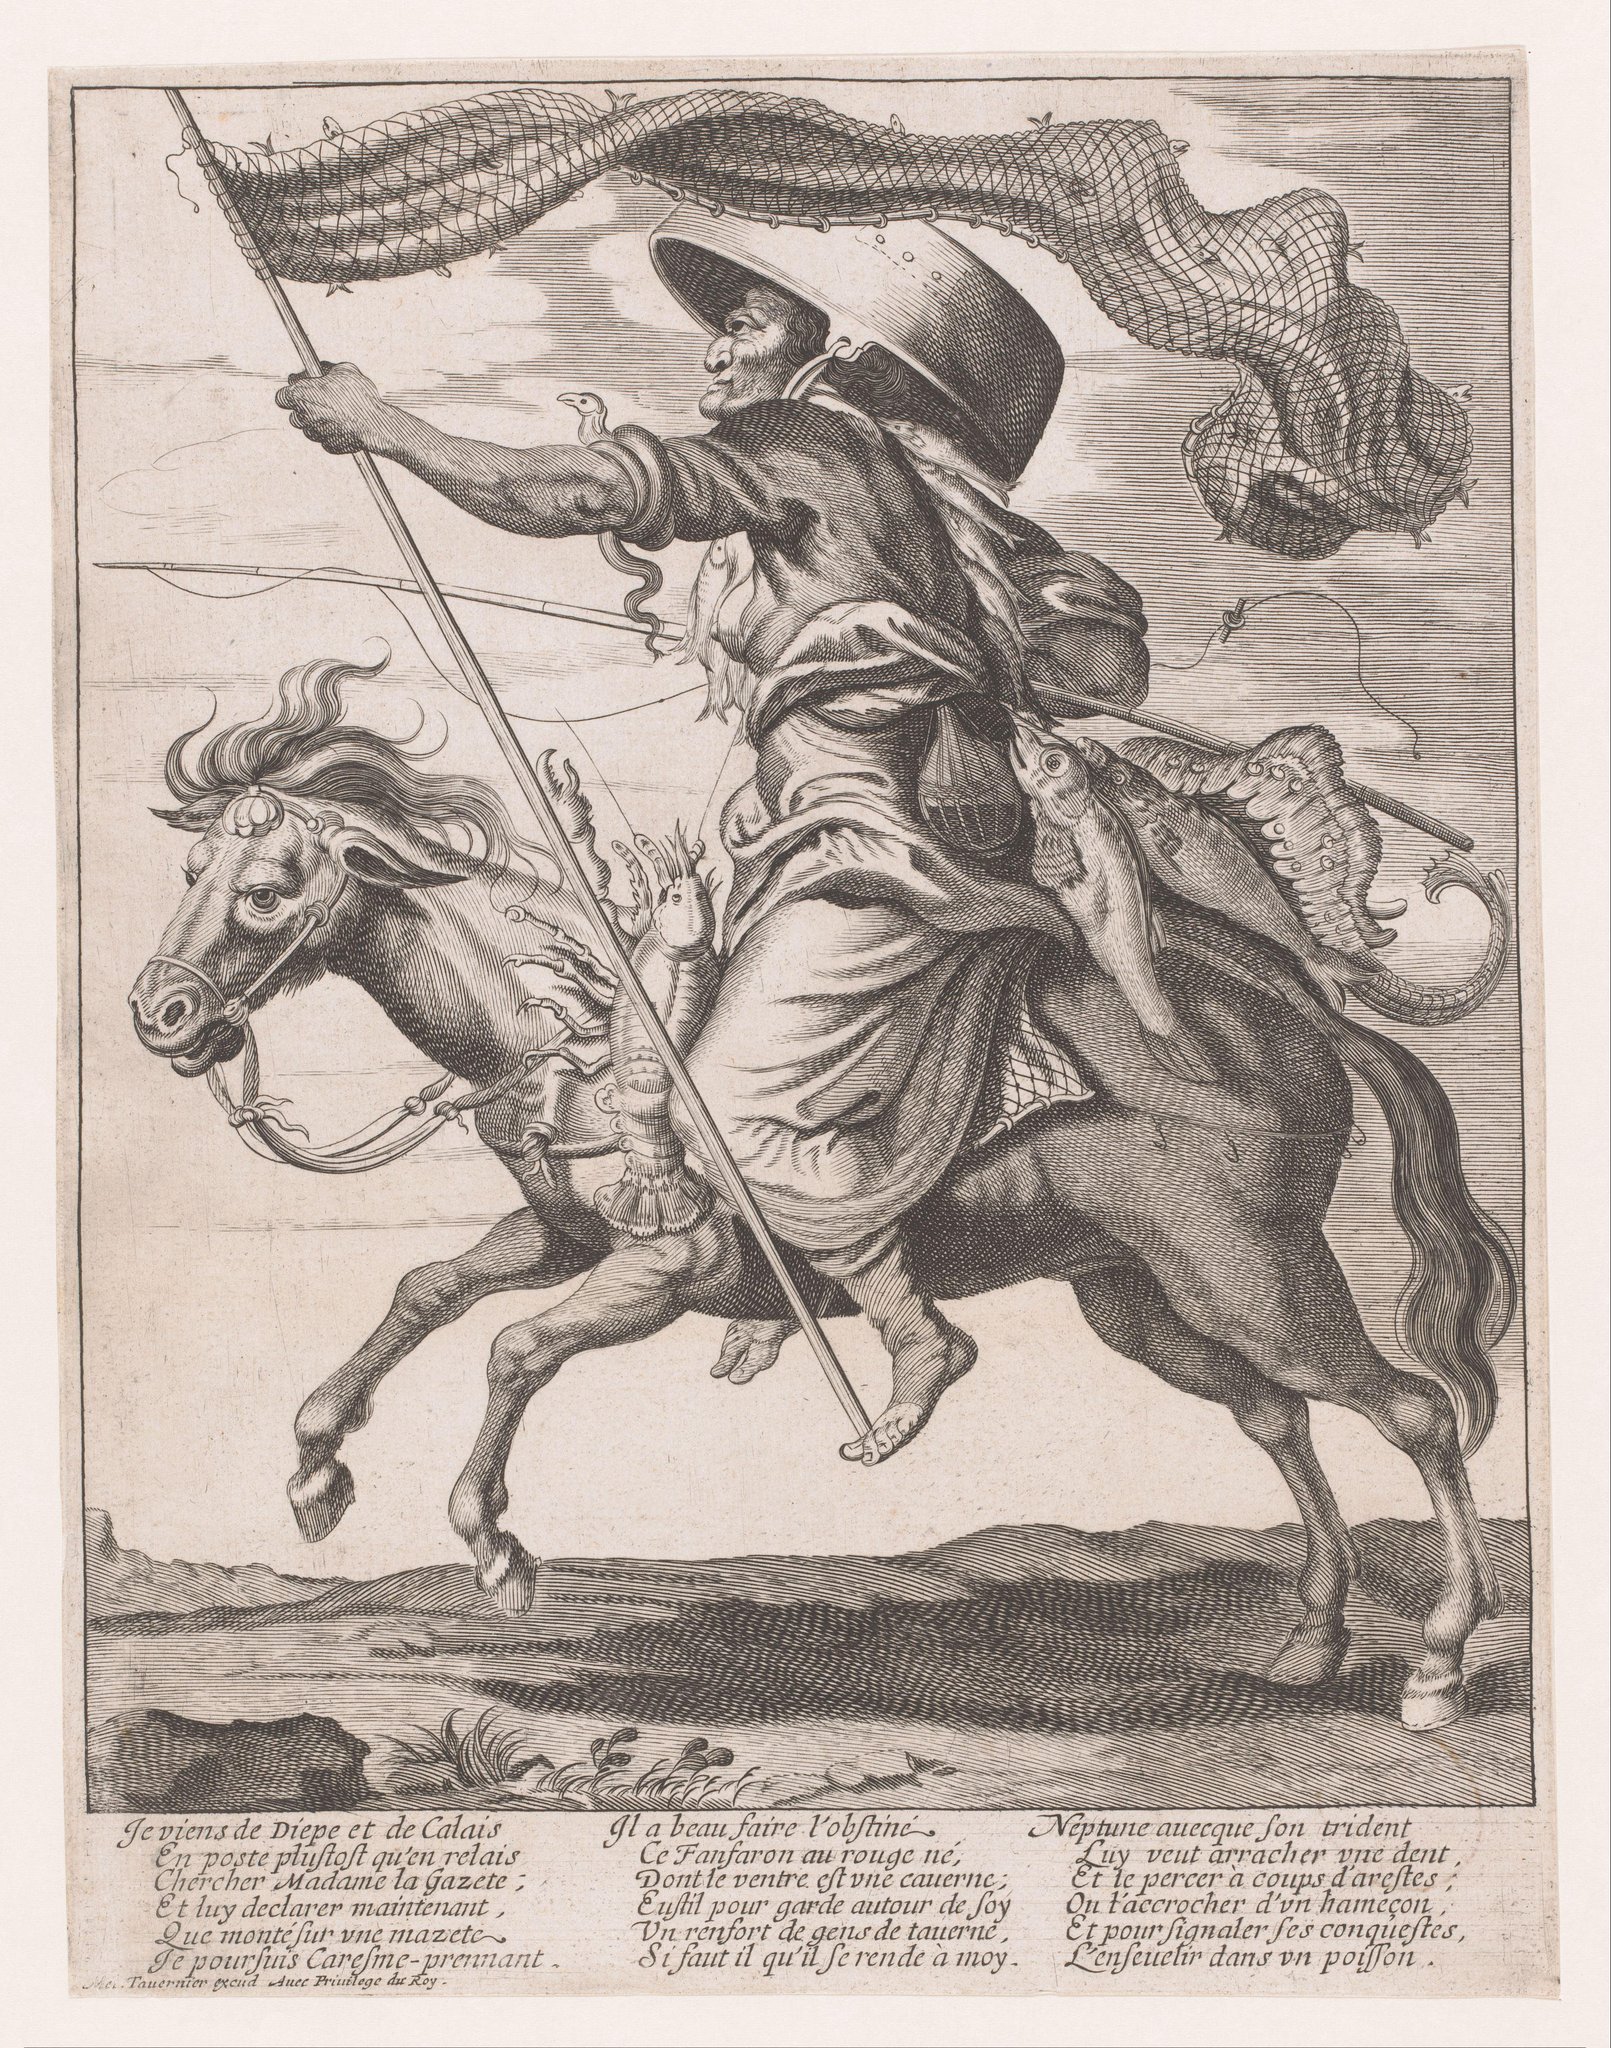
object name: print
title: Vrouw op een paard, behangen met vissen en een visnet als vaandel met carnaval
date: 1574-1641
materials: paper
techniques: engraving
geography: france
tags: kitchen-utensils: pan, fishing net, fishes, crustaceans: lobster, shrove tuesday, 'mardi gras' ~ non-liturgical celebrations of carnival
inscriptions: collector's mark: Lugt 240